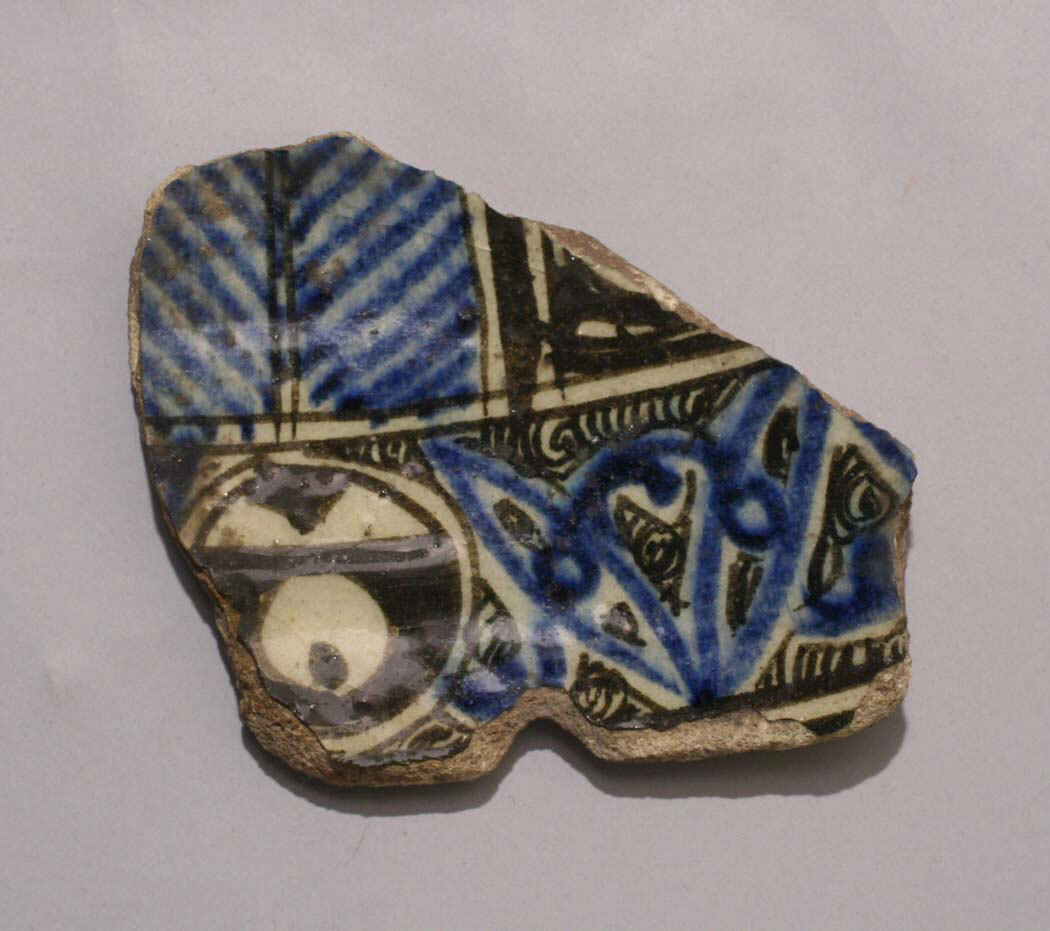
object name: fragment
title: Ceramic Fragment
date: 1301-1500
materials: stonepaste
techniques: painting, polychrome, underglaze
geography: syria